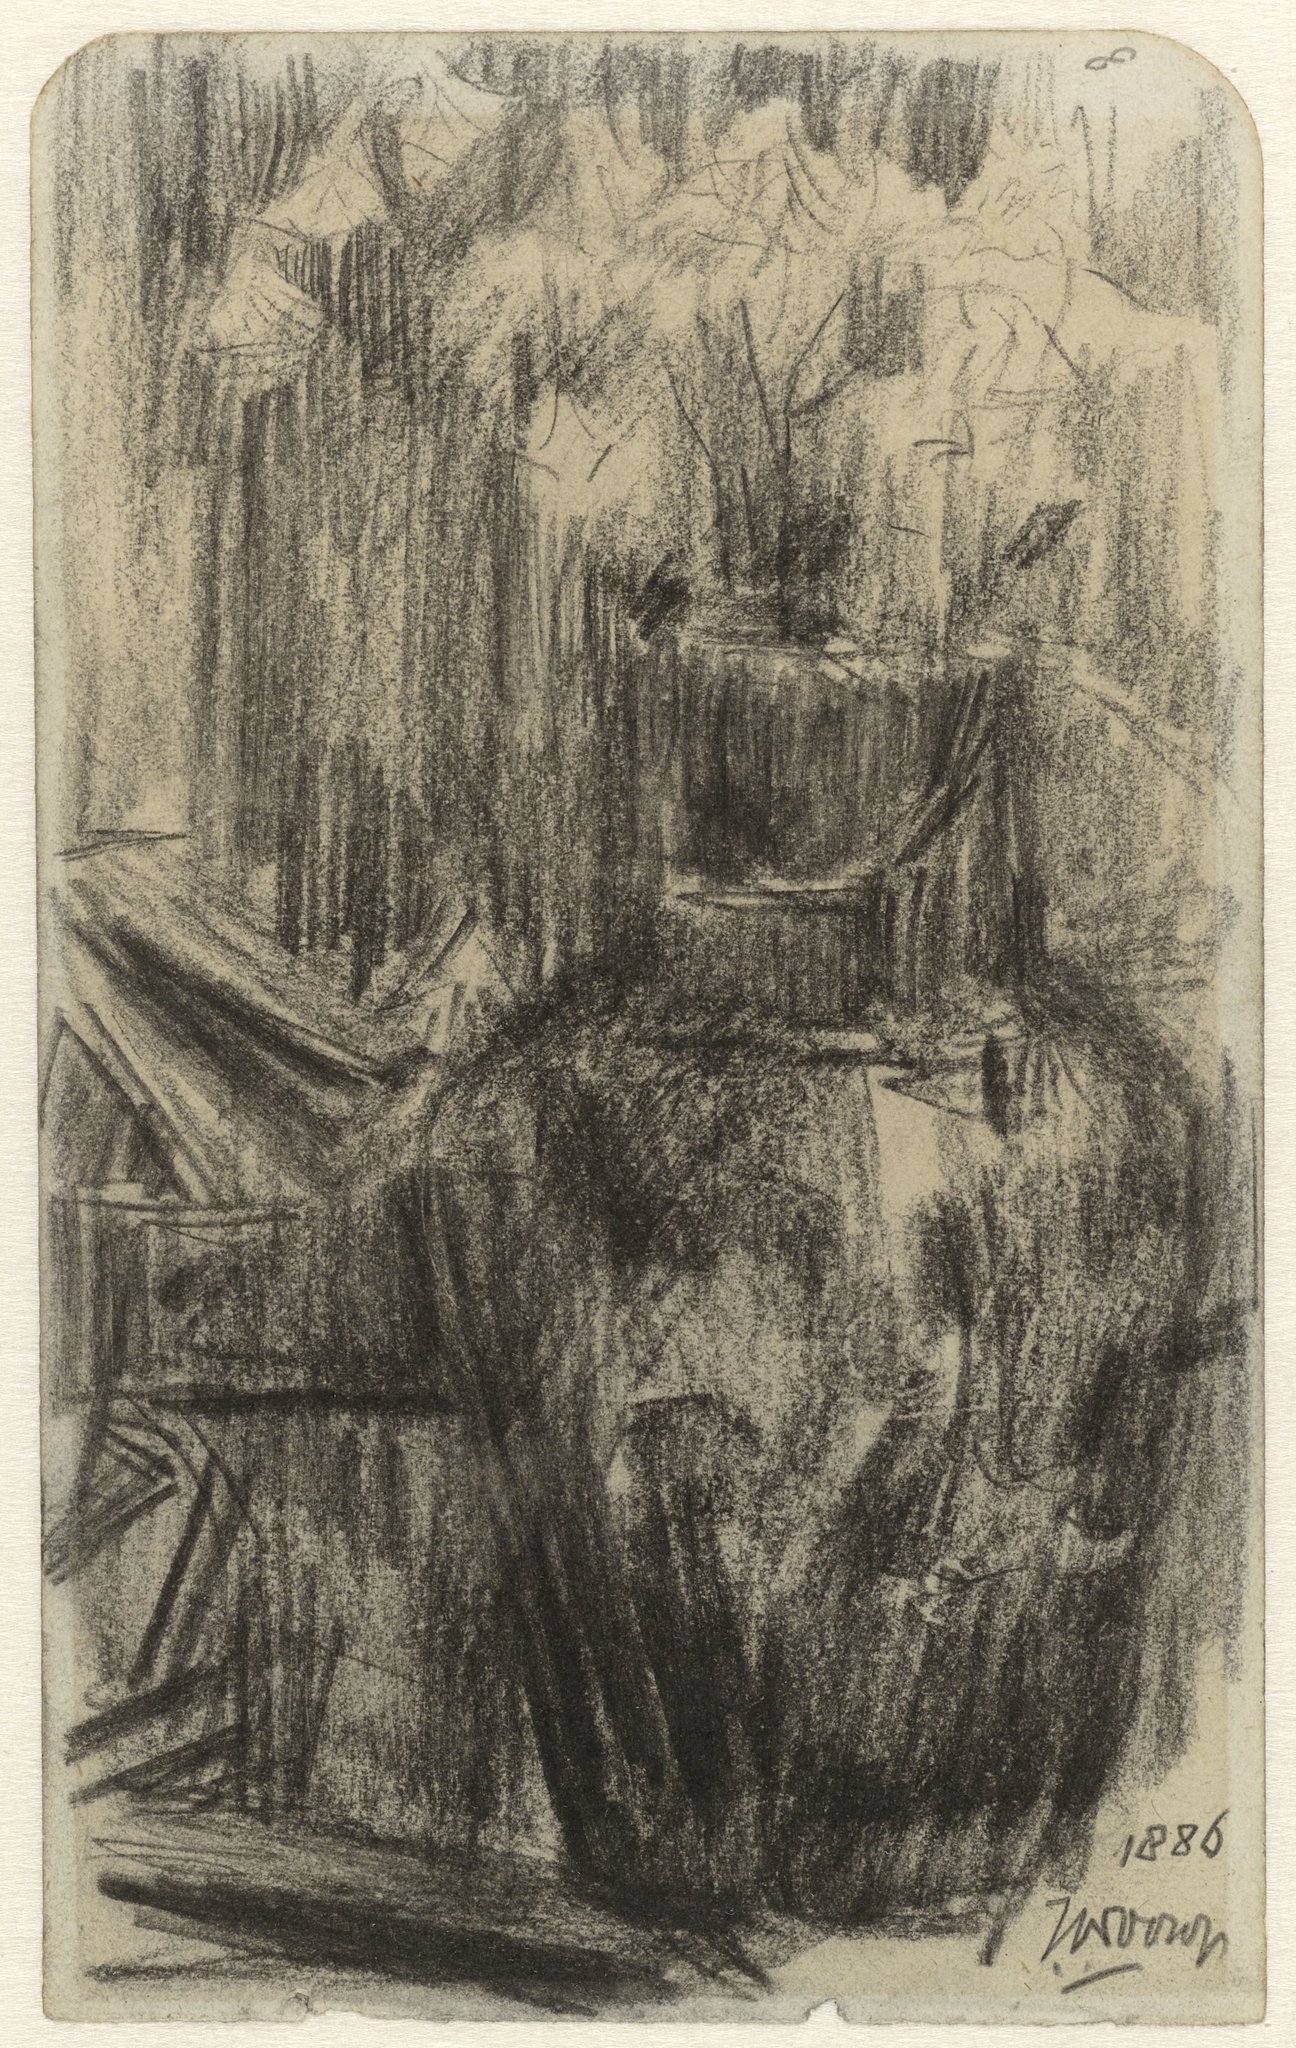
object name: drawing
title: Vaas met bloemen in een interieur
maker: jan toorop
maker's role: draughtsman, painter, print maker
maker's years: 1858-1928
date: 1886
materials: chalk, paper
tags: flowers in a vase